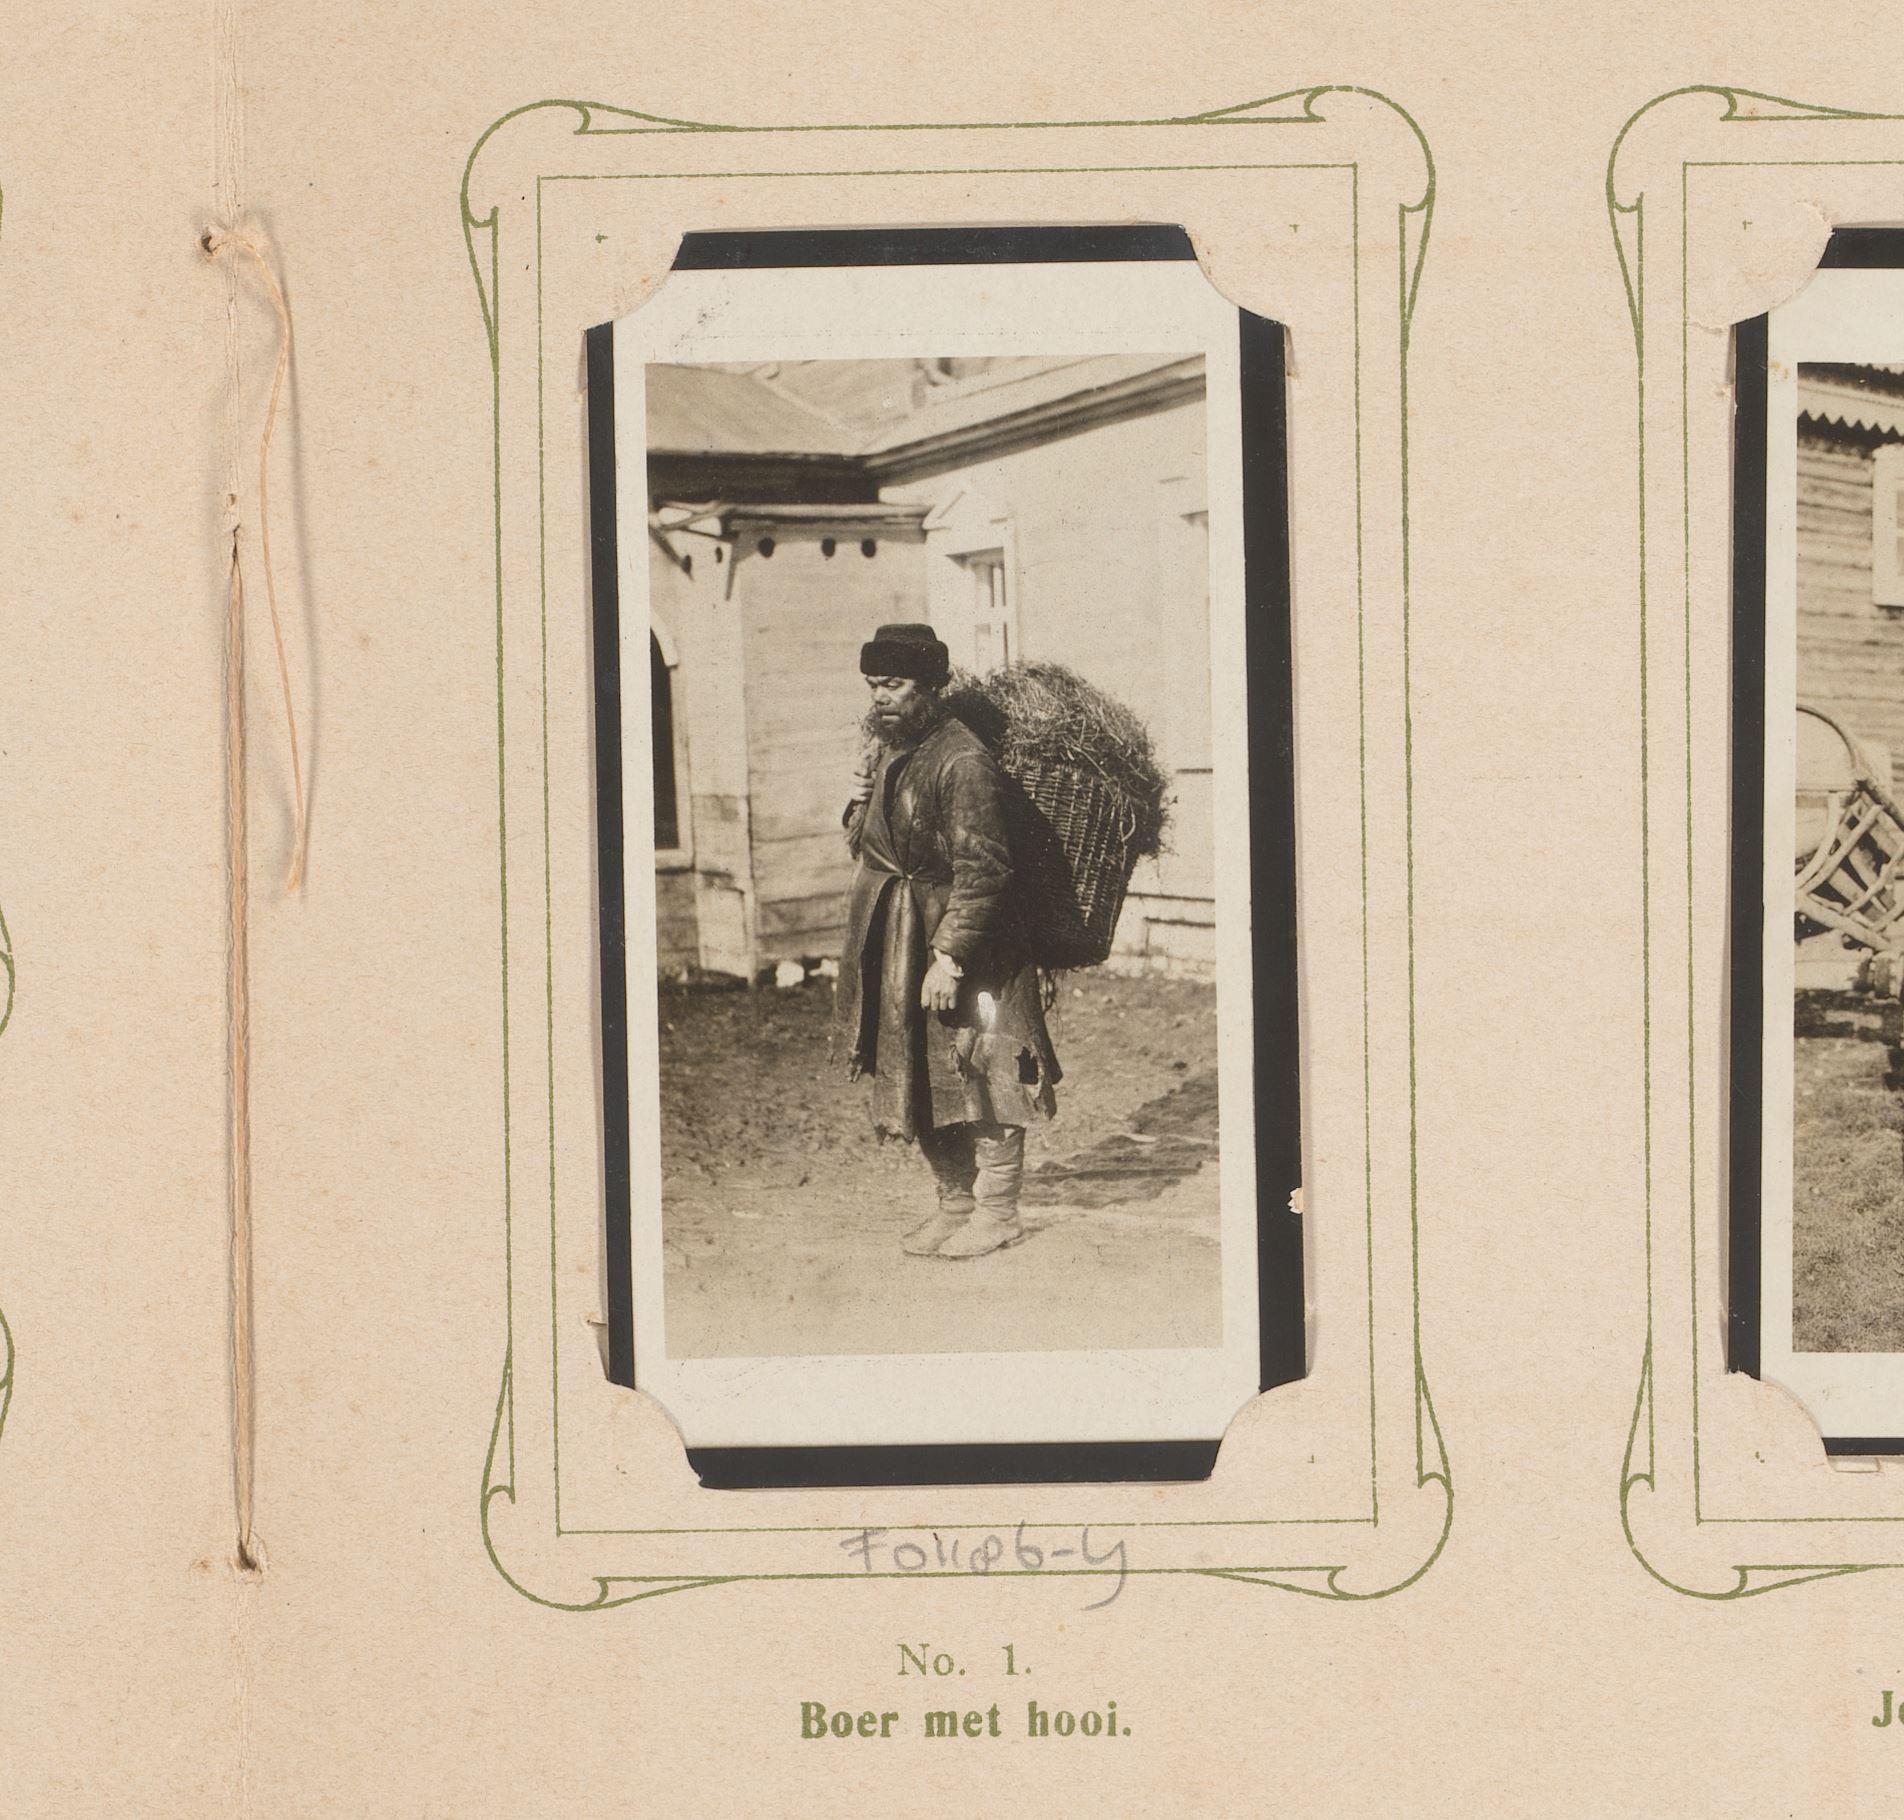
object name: album leaf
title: Russische boer met hooi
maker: Anonymous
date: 1904-1905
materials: photographic support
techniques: gelatin silver print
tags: agricultural products and by-products: hay, farmers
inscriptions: inscription: ‘No. 1./ Boer met hooi.’